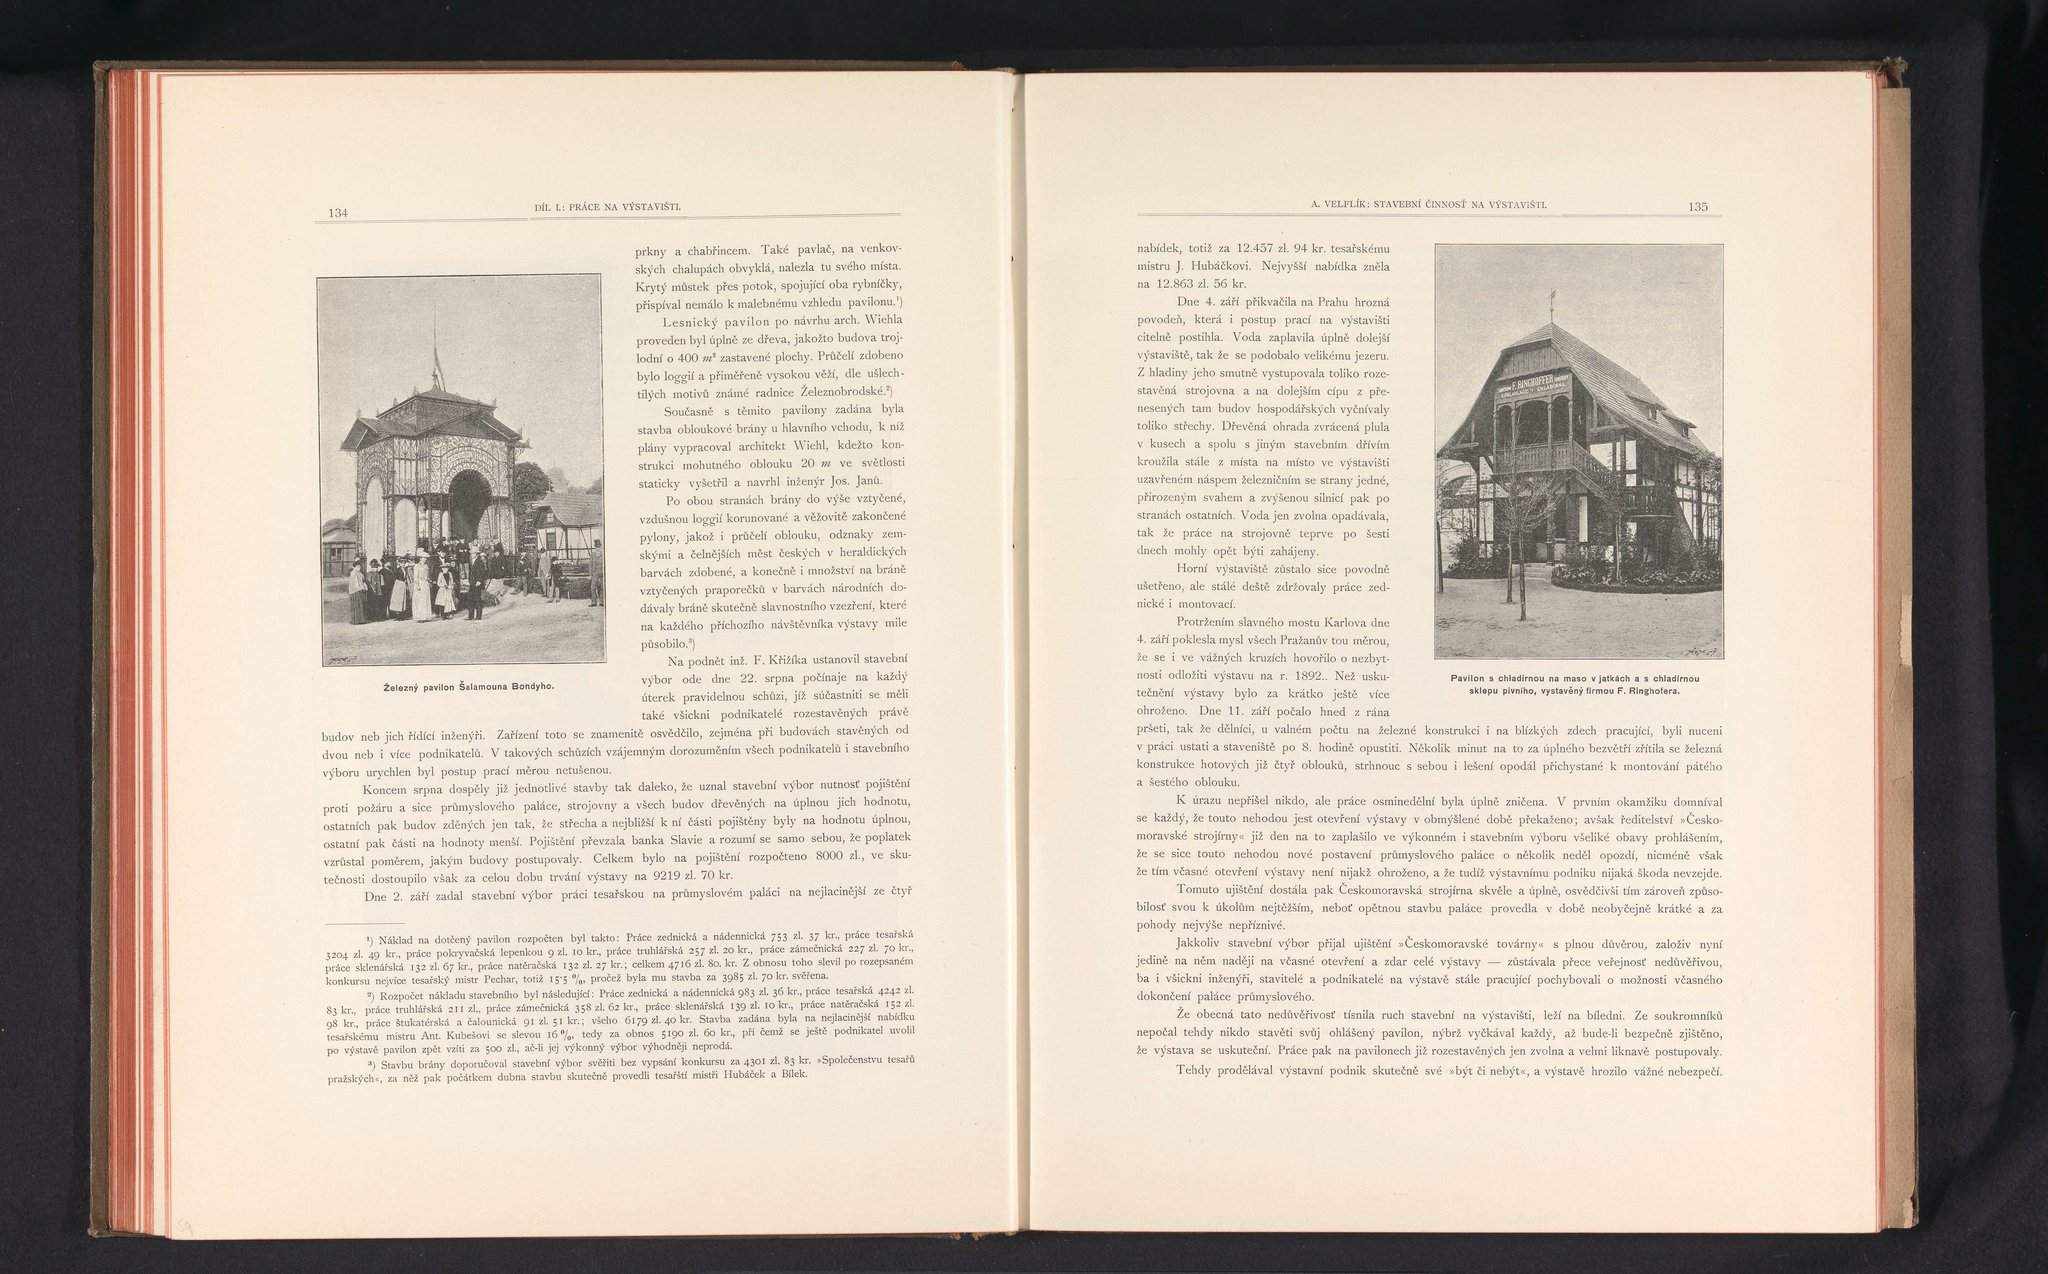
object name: photomechanical print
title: Paviljoen op het Výstaviště te Praag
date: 1888-1893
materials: paper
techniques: autotype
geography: výstaviště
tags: façade (of house or building), temporary exhibition, 'salon'